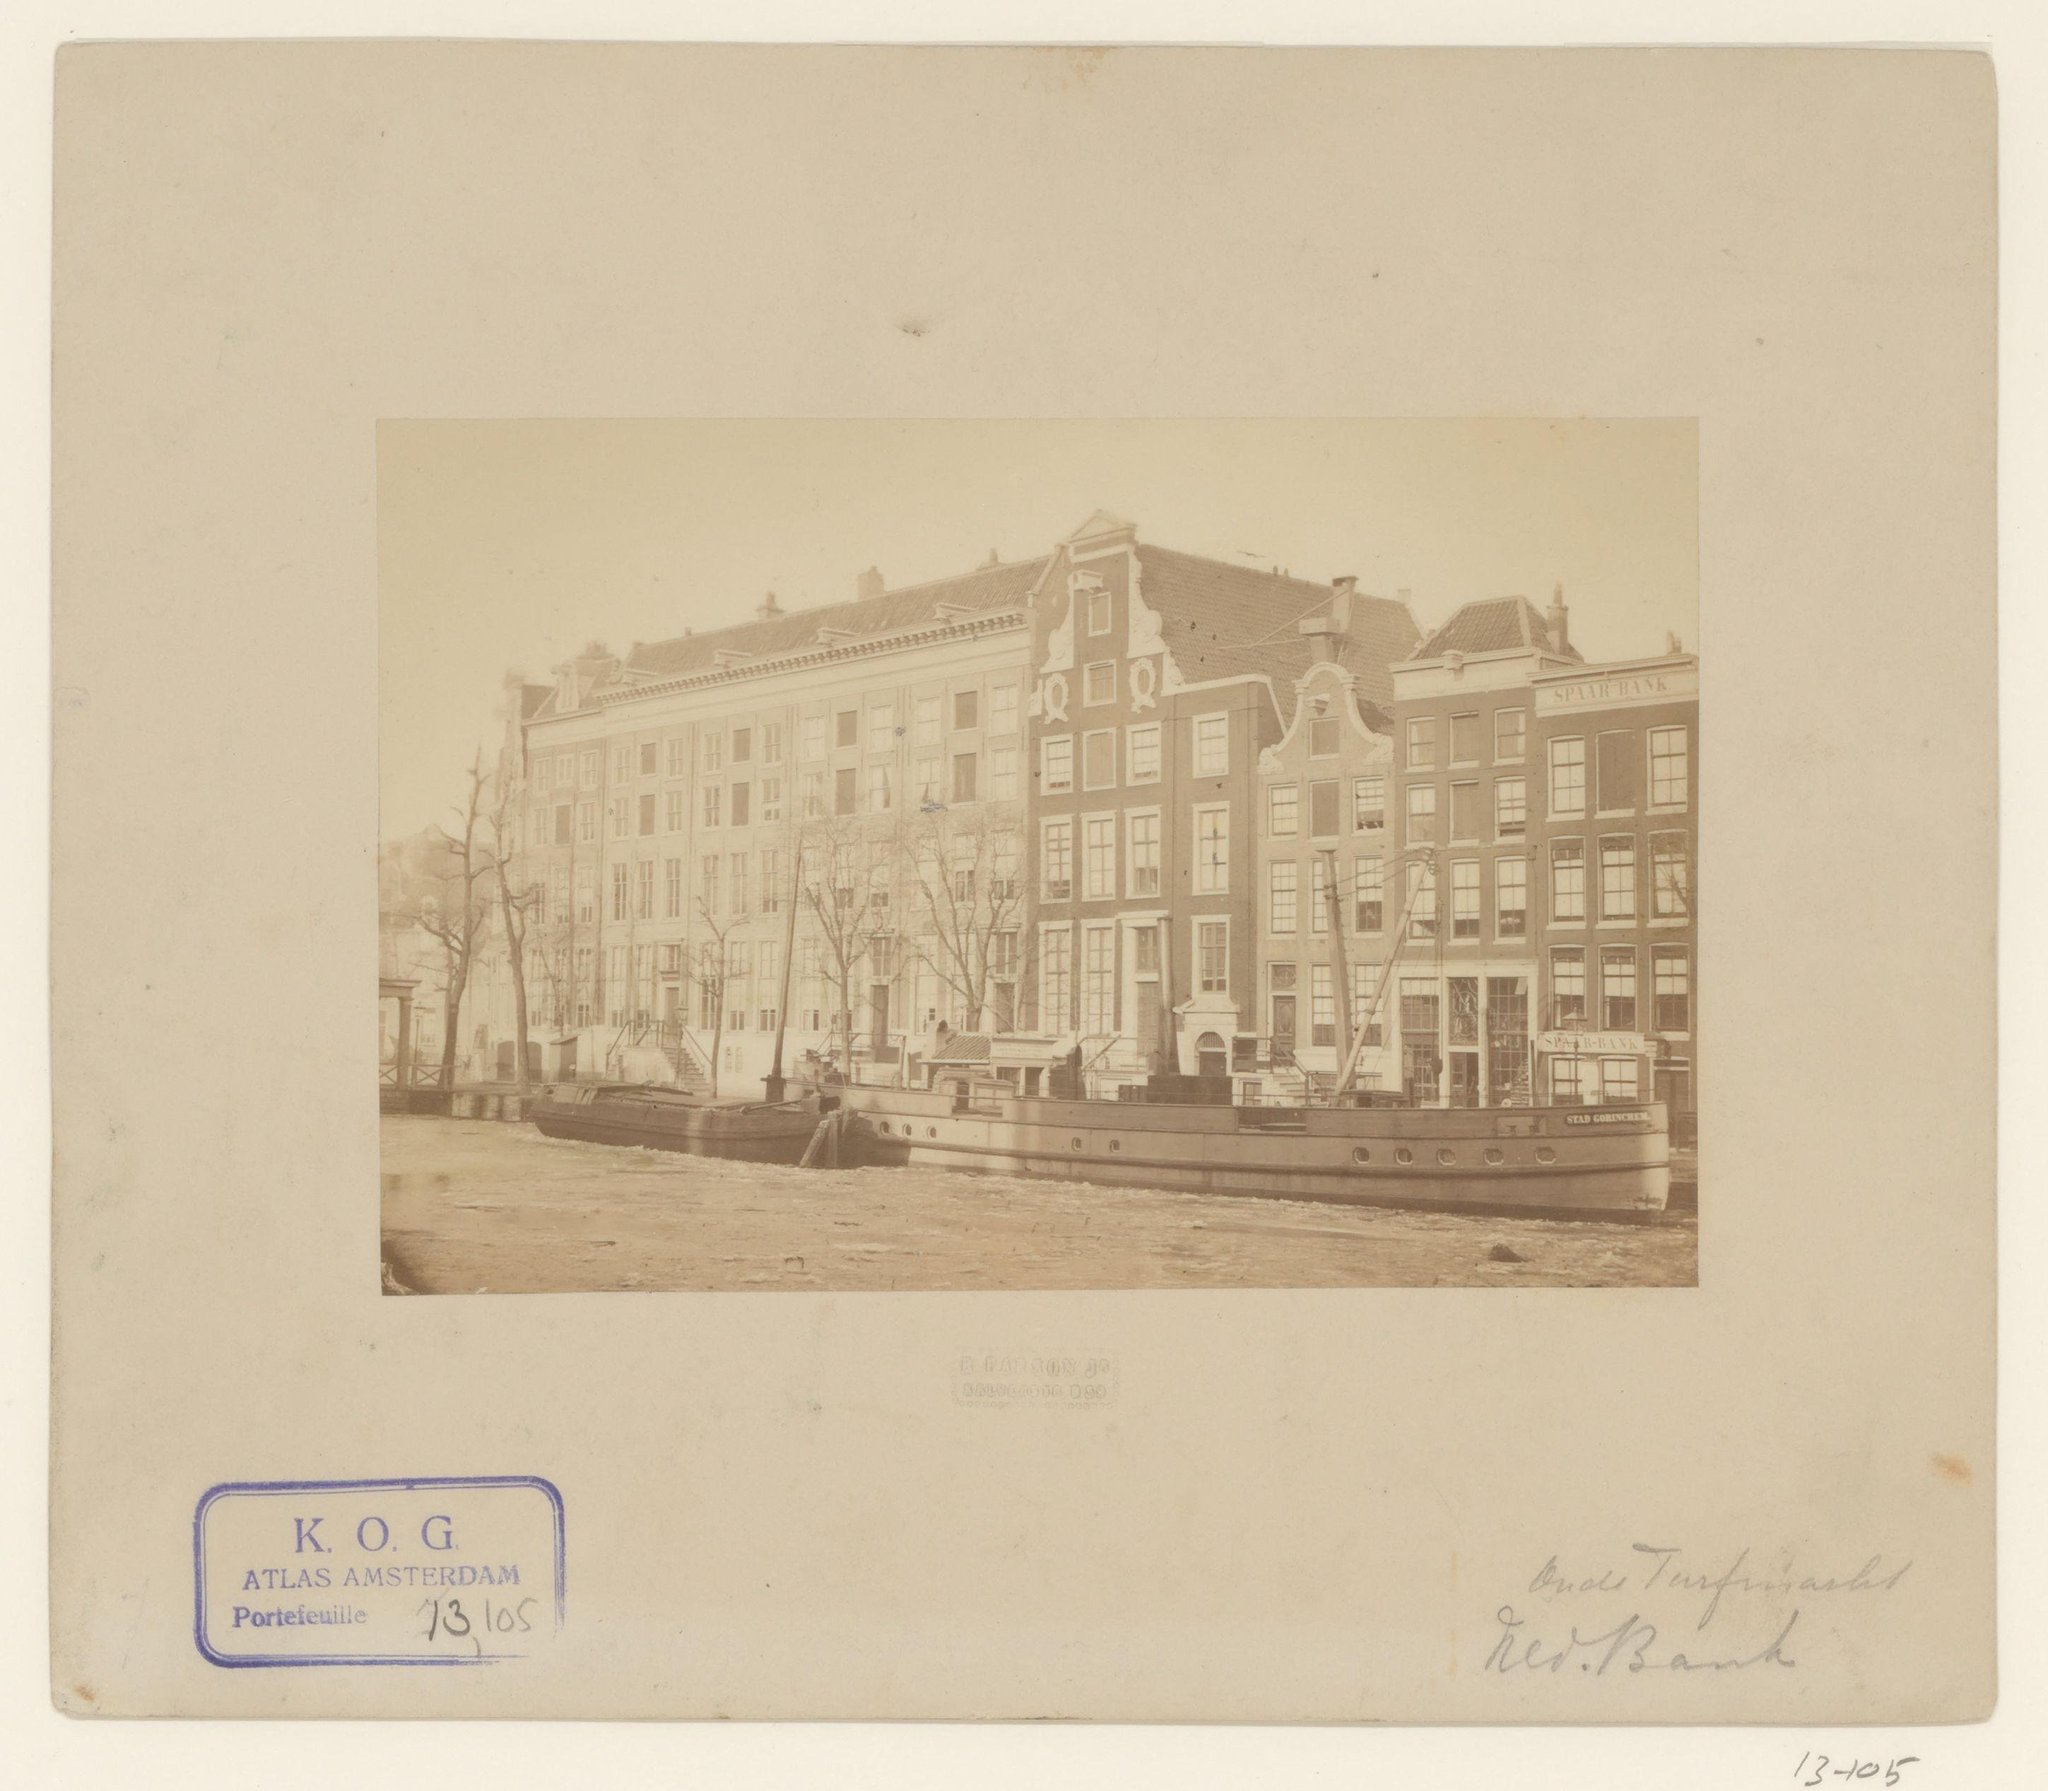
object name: cabinet photograph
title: Gezicht op De Nederlandsche Bank aan de Oude Turfmarkt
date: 1869-1896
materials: cardboard, paper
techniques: albumen print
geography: amsterdam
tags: city-view in general; 'veduta', canal, façade (of house or building), bank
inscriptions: inscription: ‘Oude Turfmarkt / Ned. Bank’, collector's mark: ‘13,105’ Lugt 1641b, check stamp: ‘H. Parson Jr. / Kalverstraat N59’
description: Onderwerpsrubriek binnen de Atlas Amsterdam: Taanstraat, Teertuinen (Nieuwe), Thorbeckeplein, Tolhuis, Tuinstraat (Kromme), Turfmarkt (Oude), Uilenburgergracht, Uilenburgerstraat, Utrechtsestraat.